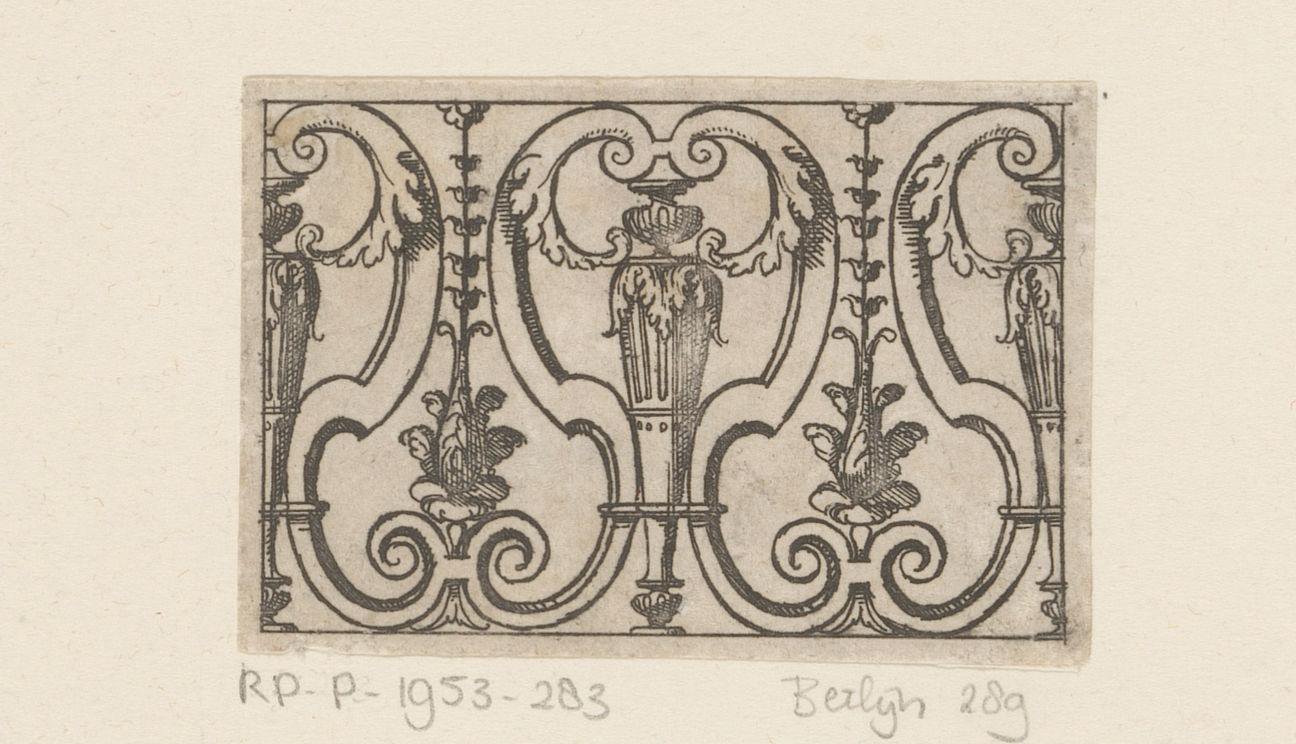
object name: ornament print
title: Vlechtwerk in hartvorm met vazen en bloemen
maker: jacques androuet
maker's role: draughtsman, print maker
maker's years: 1515-1584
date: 1520-1584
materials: paper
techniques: etching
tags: interlace ~ ornament, vase ~ ornament, flowers ~ ornament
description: S-vormige voluten die spiegelbeeldig tegen elkaar gezet zijn. Tussen de voluten bevinden zich afwisselend een baluster en een toef met bladeren.